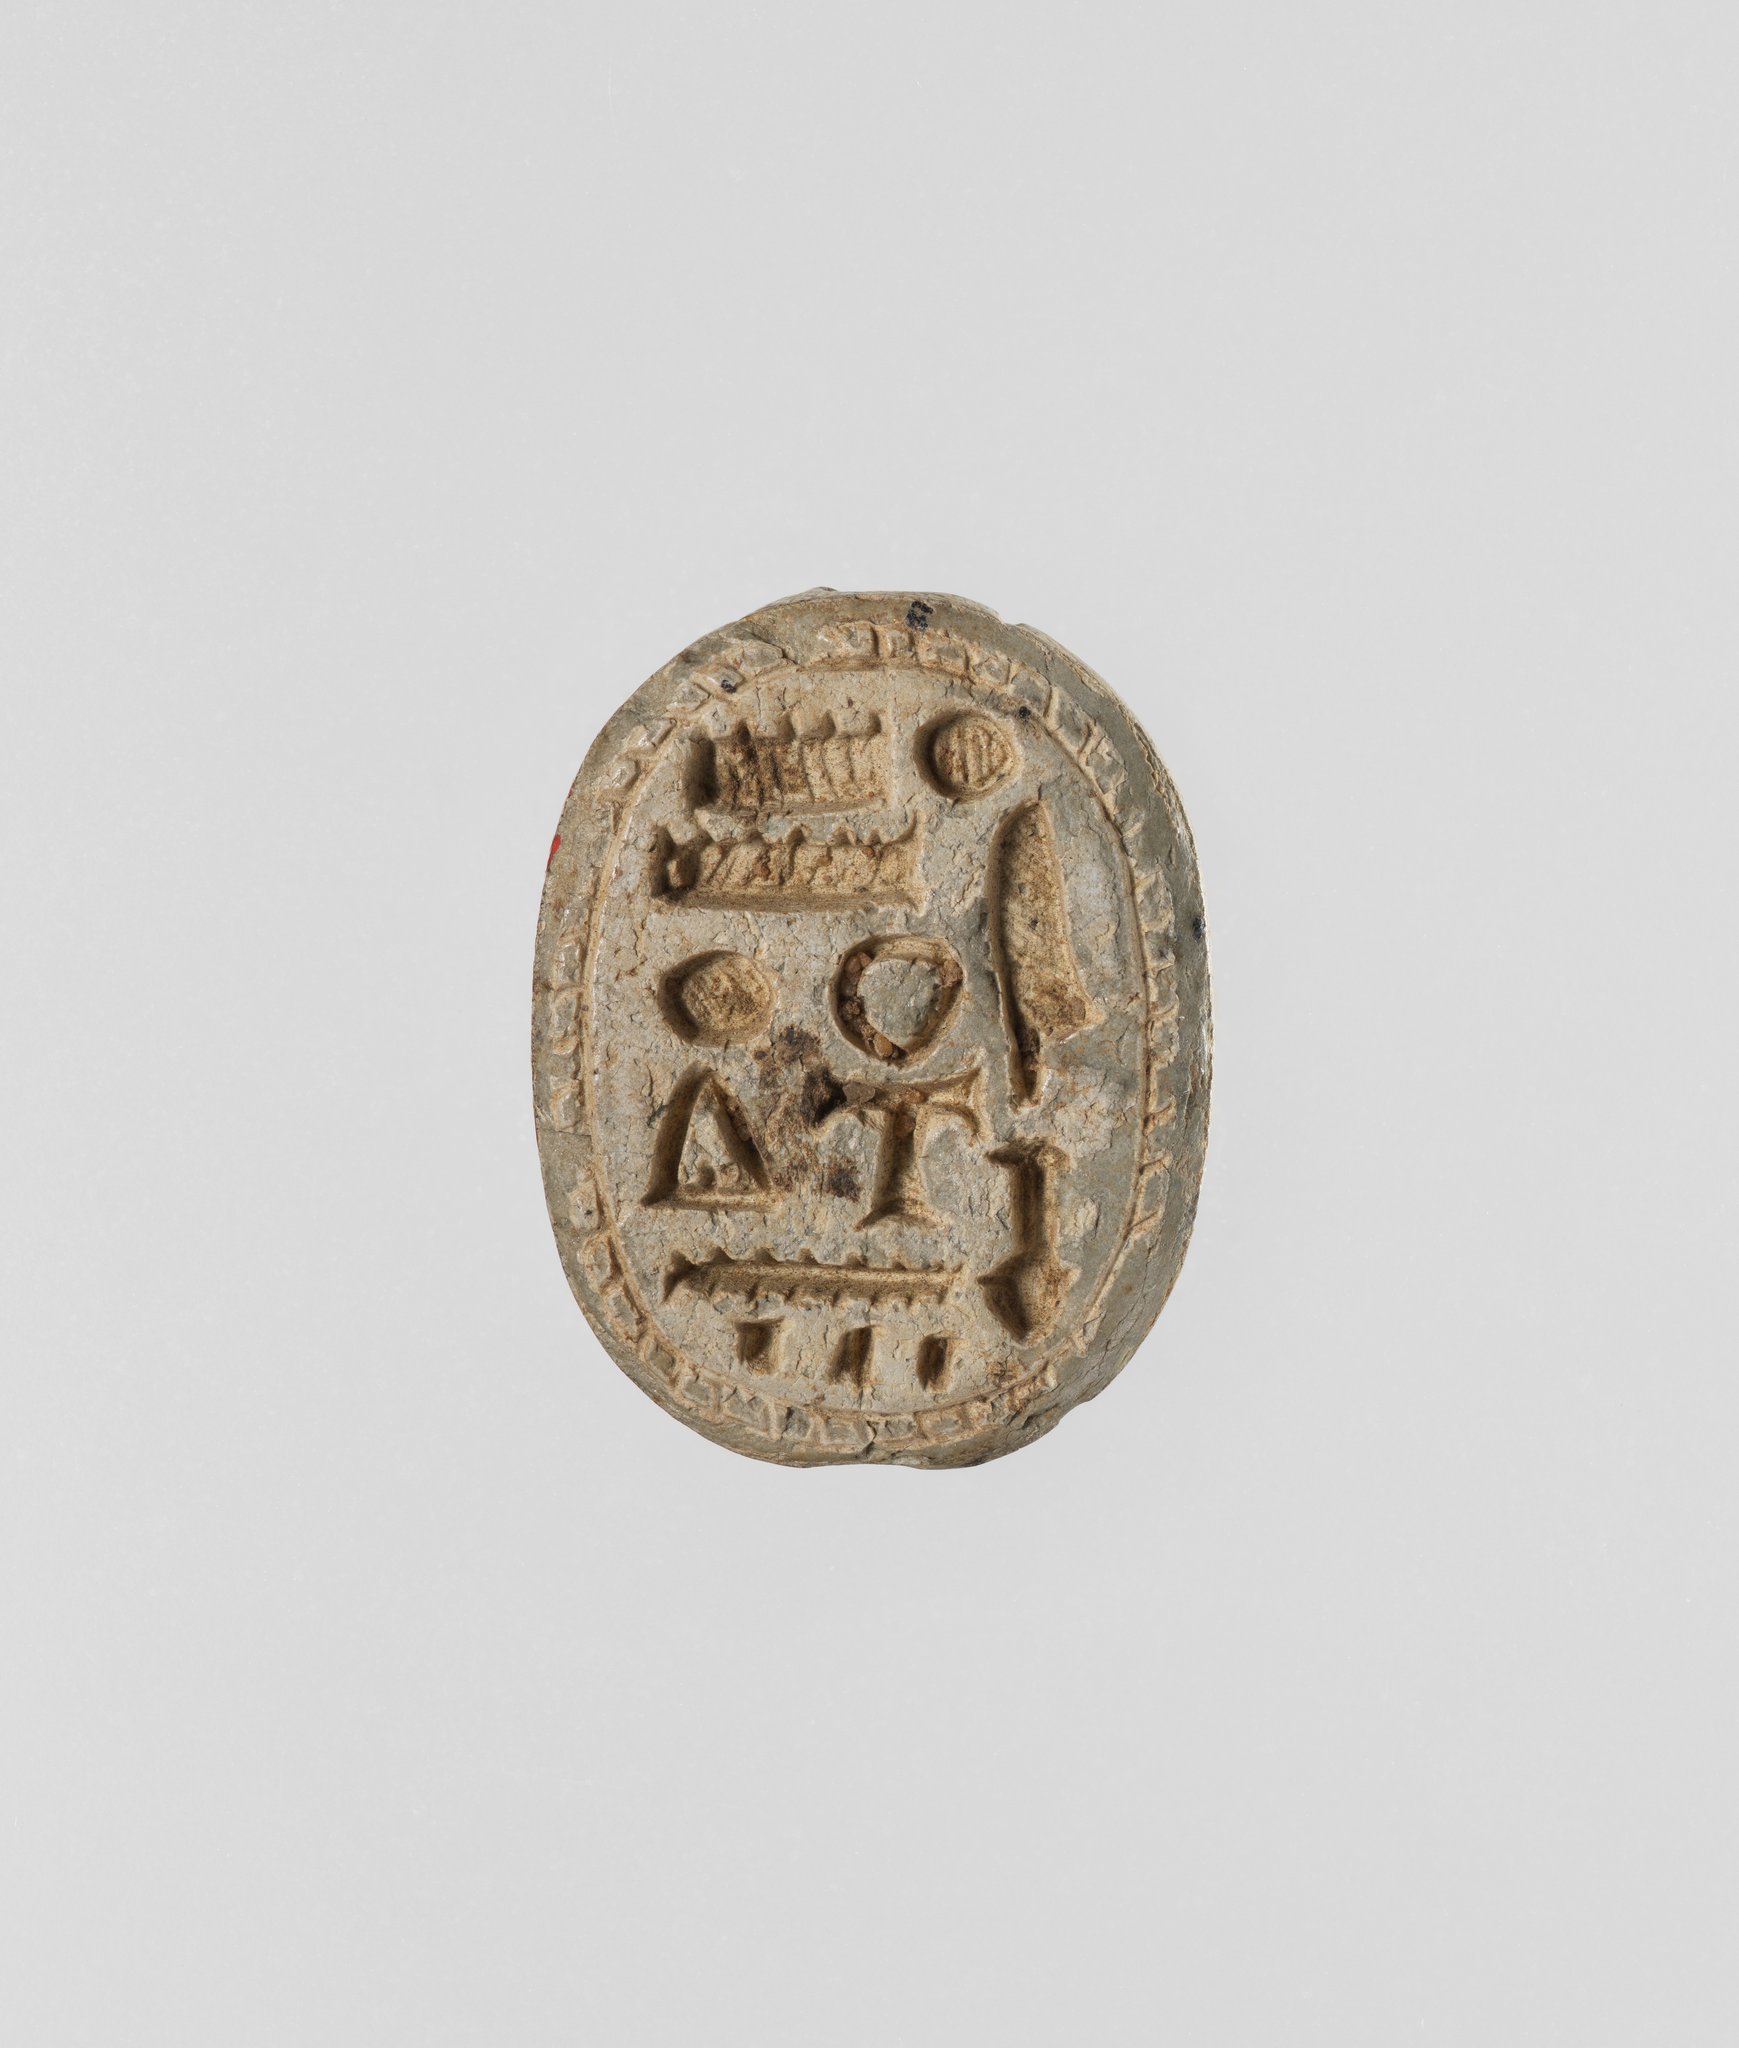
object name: scarab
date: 750-300 BCE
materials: stone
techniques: glazing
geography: nubia